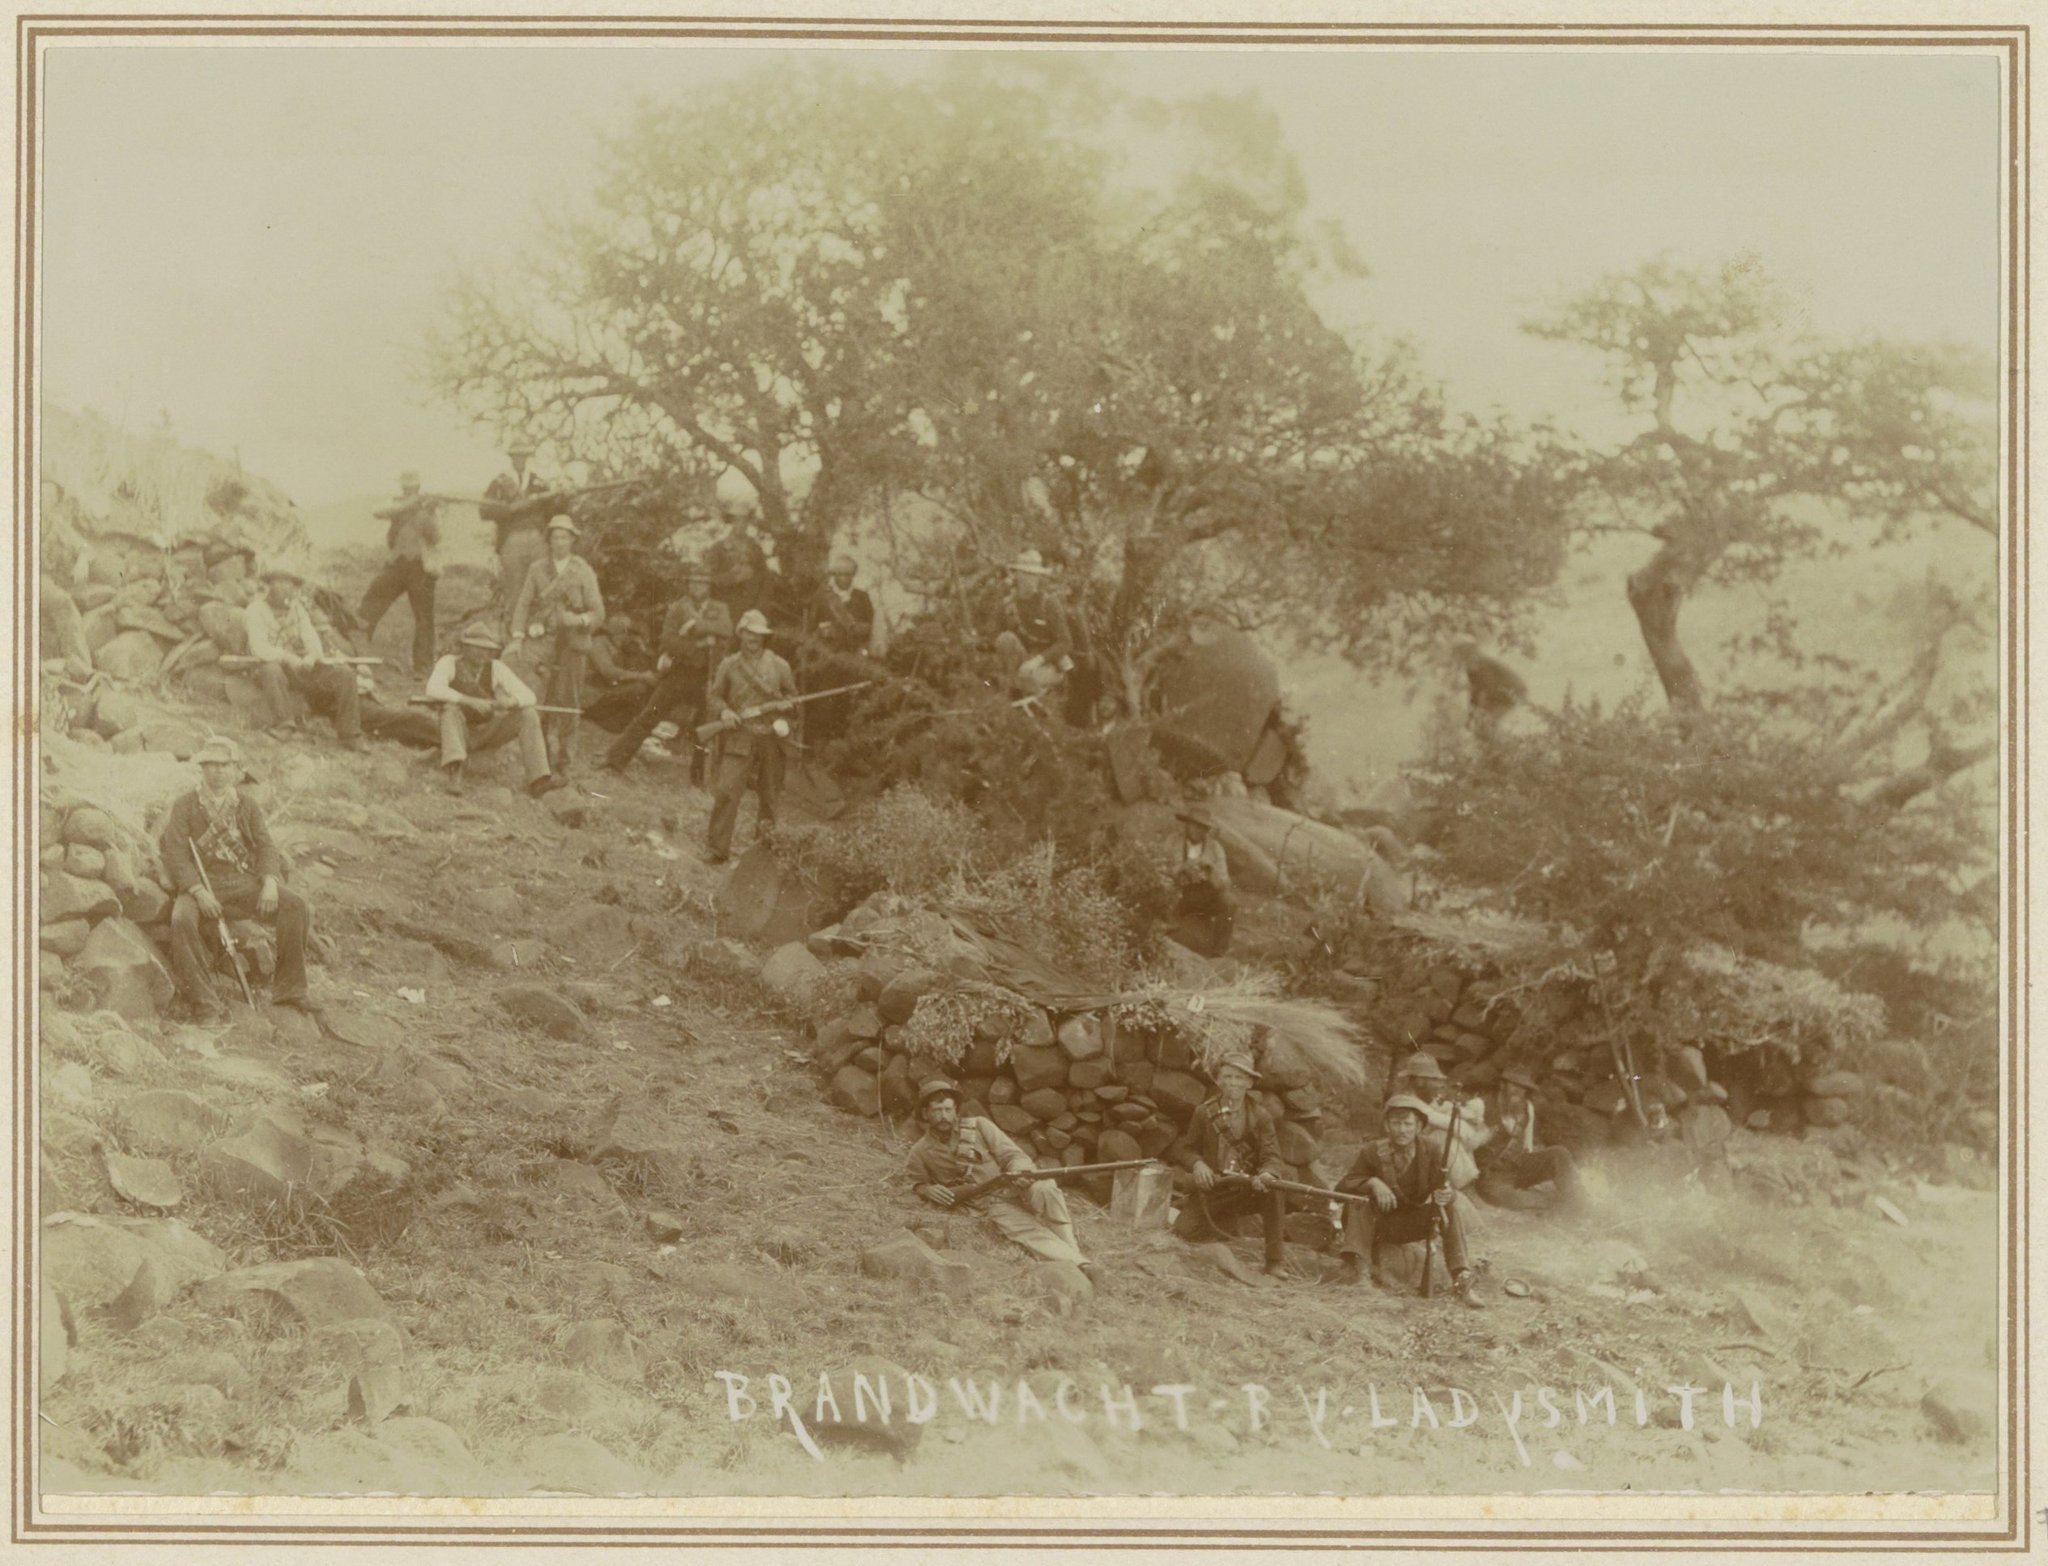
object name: album leaf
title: Patrouille brandwacht poserend op een heuvel in Zuid-Afrika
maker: Anonymous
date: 1899-1900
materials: cardboard, paper, photographic support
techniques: gelatin silver print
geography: south africa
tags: land forces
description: Onderdeel van Fotoalbum met opnames van de Tweede Boerenoorlog (1899-1902).